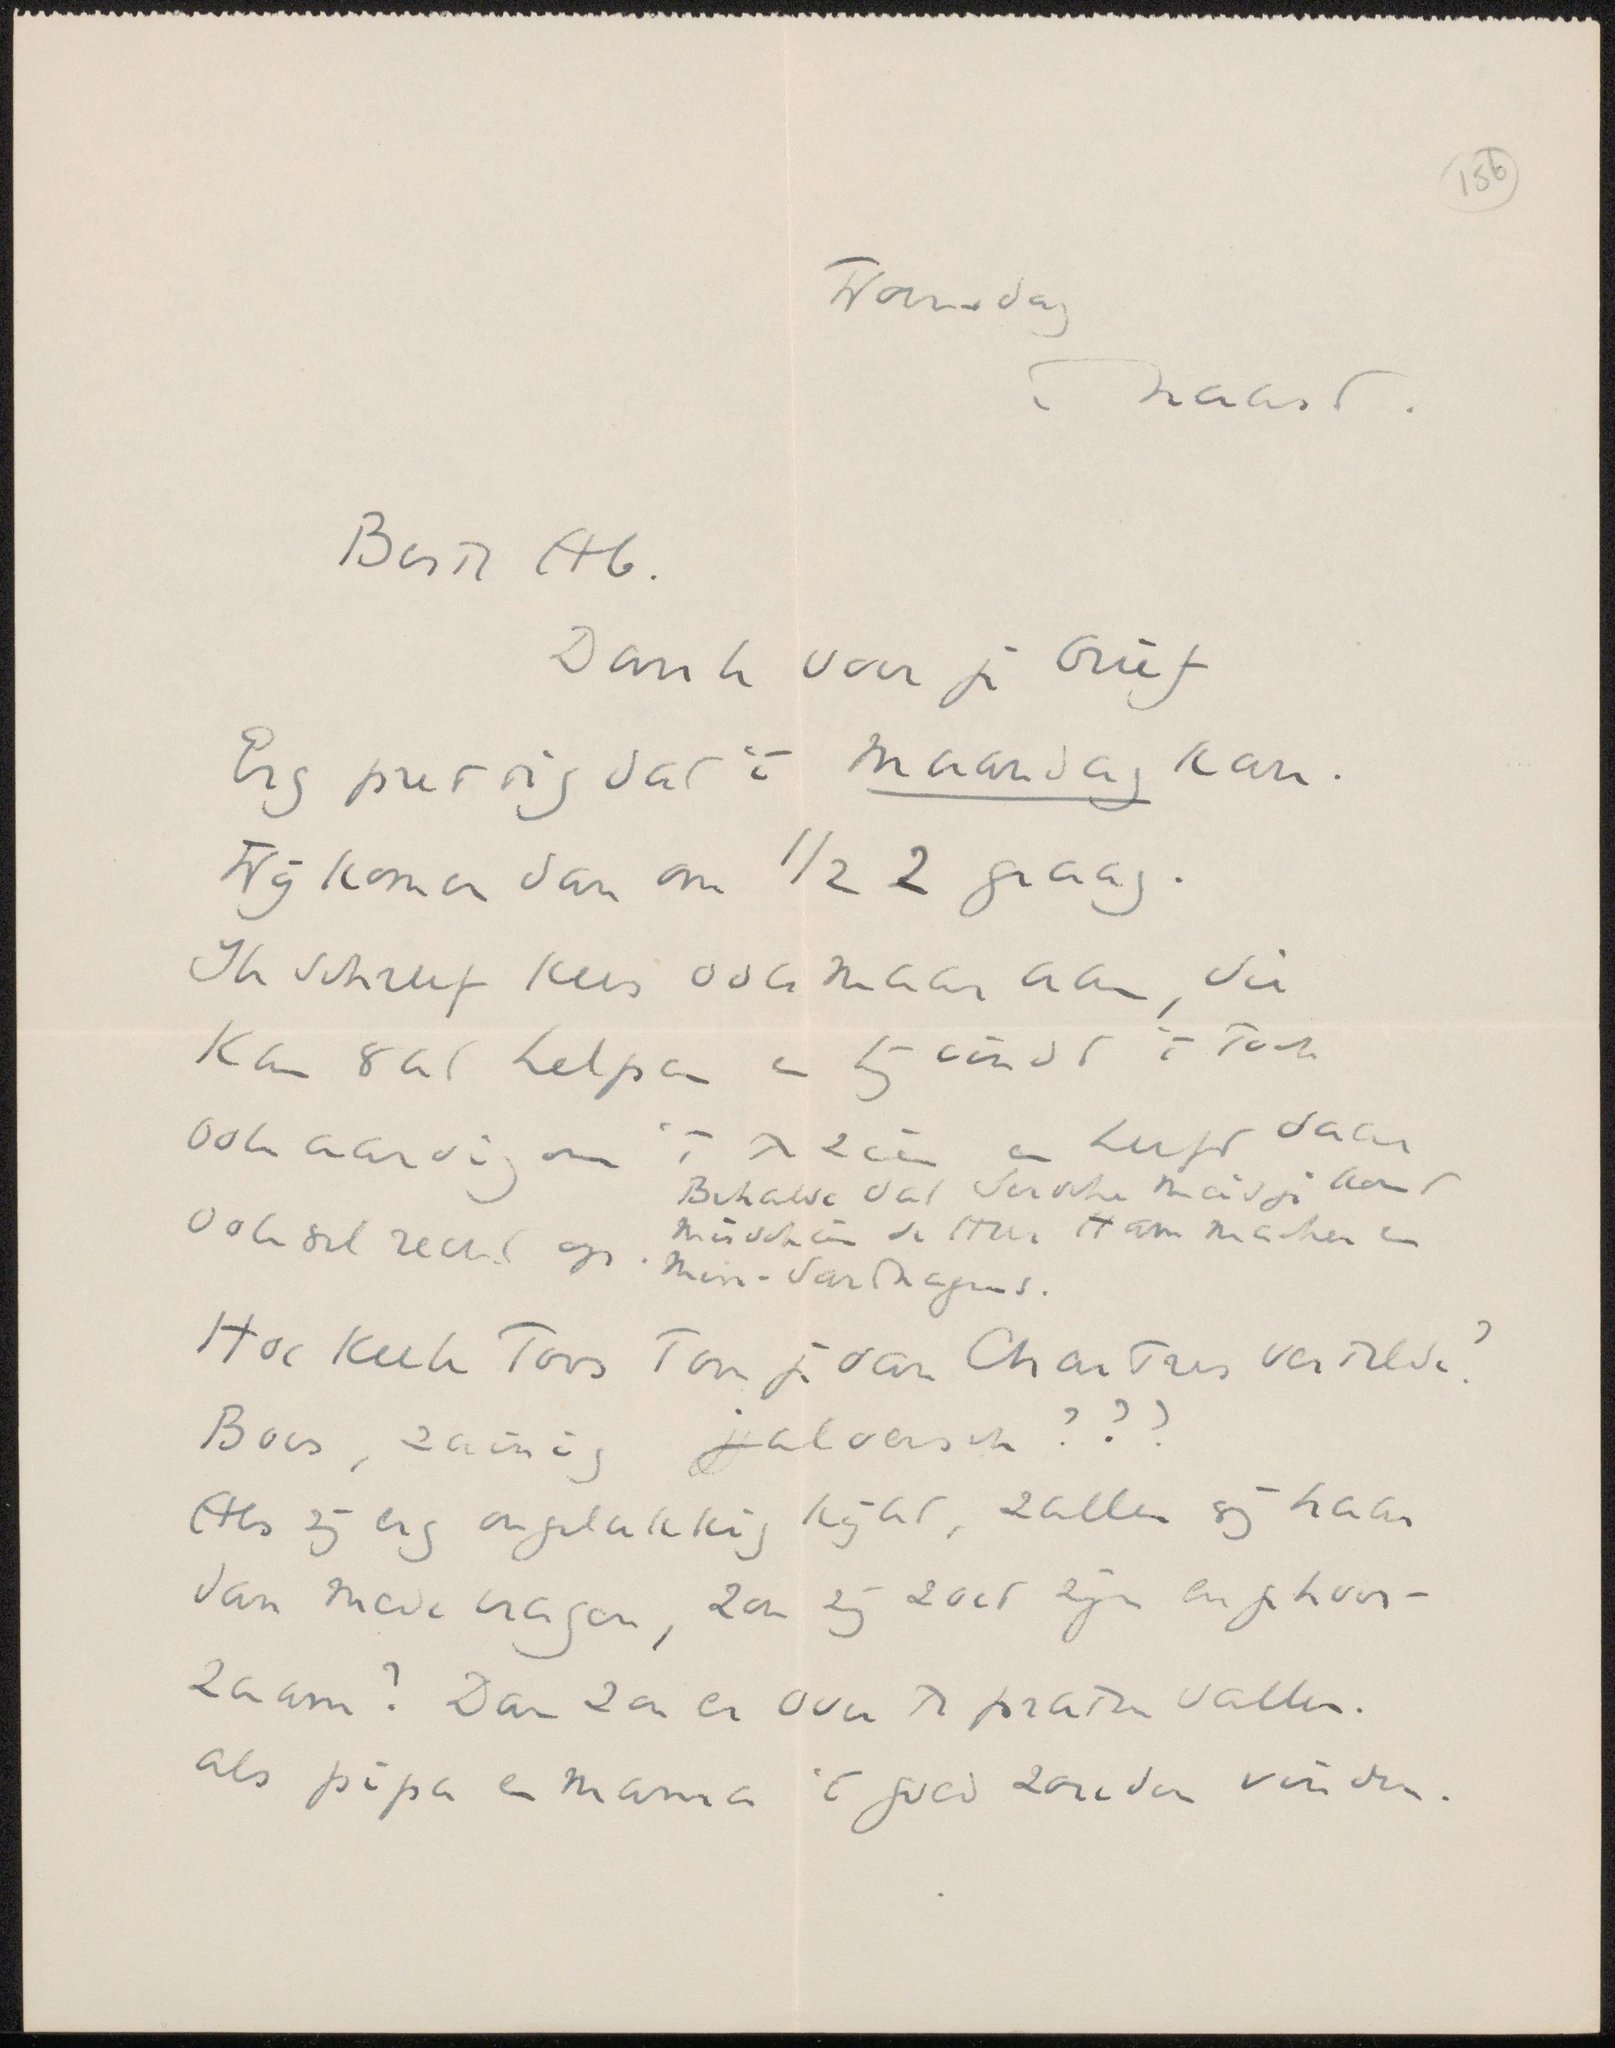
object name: letter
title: Brief aan Ab Bogtman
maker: richard nicolaüs roland holst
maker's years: 1868-1938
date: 1878-1938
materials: ink, paper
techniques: pen, writing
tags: ab bogtman, print maker, toos bogtman, bram hammacher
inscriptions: watermark